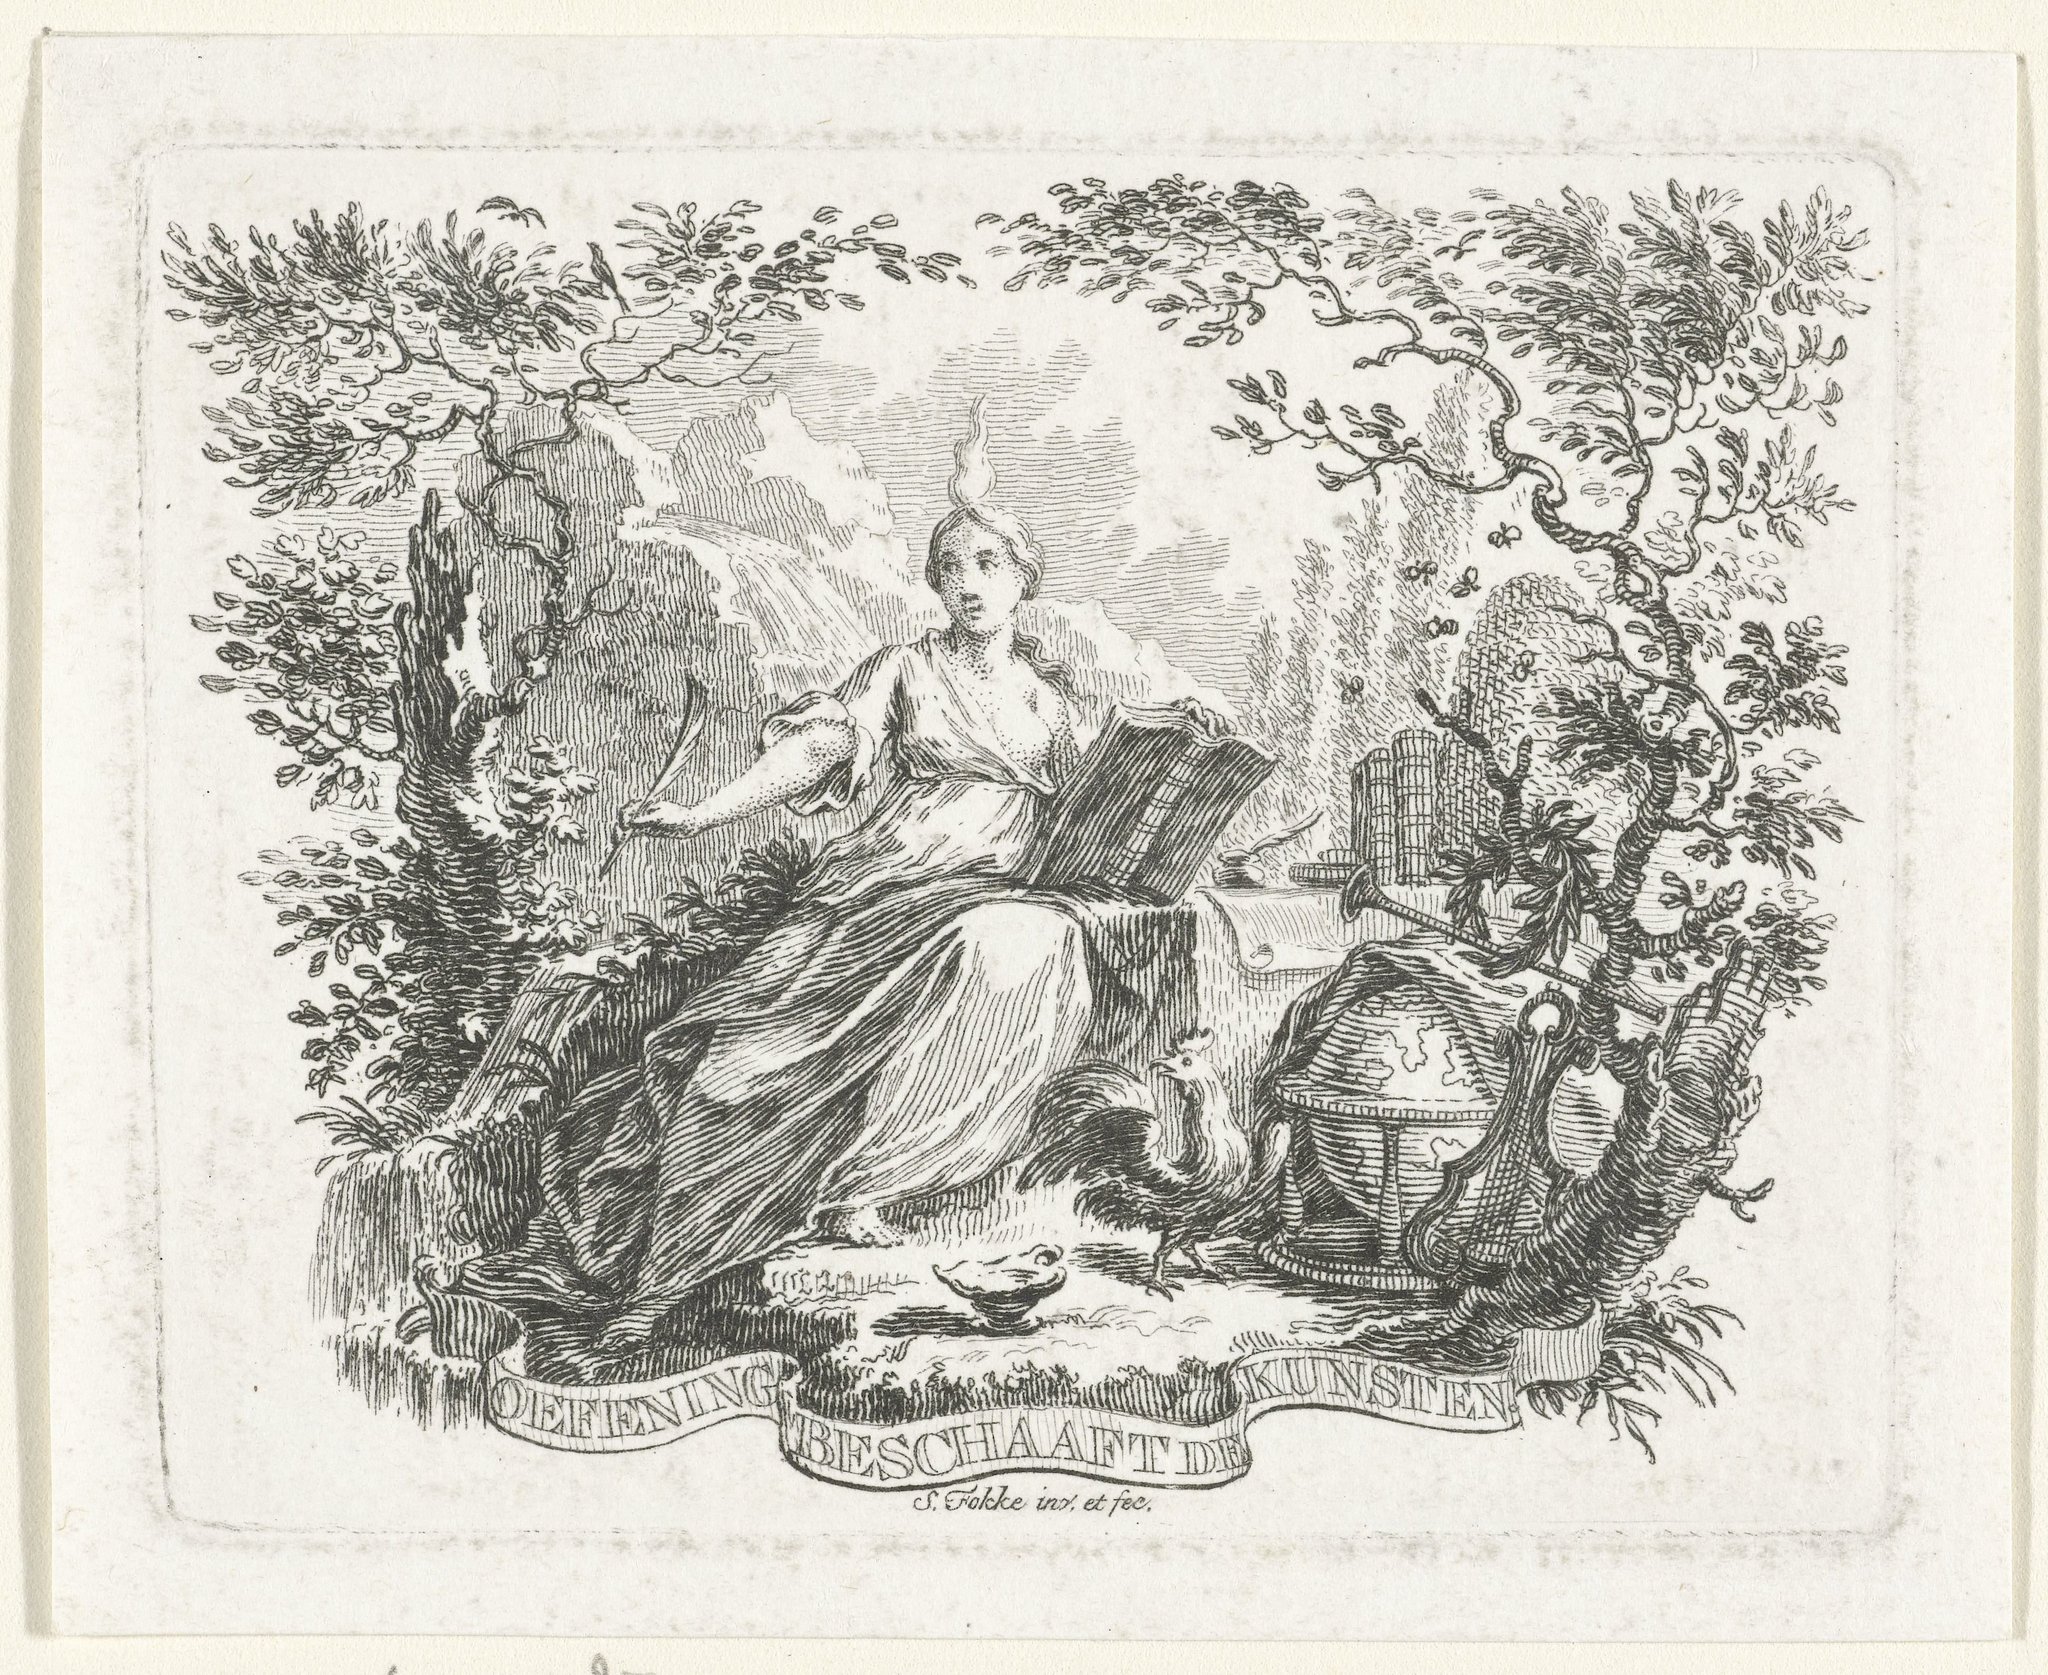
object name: print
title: Oefening beschaaft de kunsten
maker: simon fokke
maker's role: draughtsman, print maker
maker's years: 1712-1784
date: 1722-1784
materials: paper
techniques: etching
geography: amsterdam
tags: lyre, cithara, psaltery, writing tools, book, bee-hive, clarinet, bassoon, oboe, shawm, fowl (cock, hen, chicken, etc.), symbolic representations, allegories and emblems ~ art; 'arte' (ripa), globe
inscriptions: collector's mark: Lugt 2228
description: Een vrouw met een vlam boven haar hoofd houdt een opengeslagen boek en een schrijfveer vast. Naast haar een haan, wereldbol, lier en bazuin op de grond. Op de achtergrond staat een tafel met boeken, een inktpot en een bijenkorf.